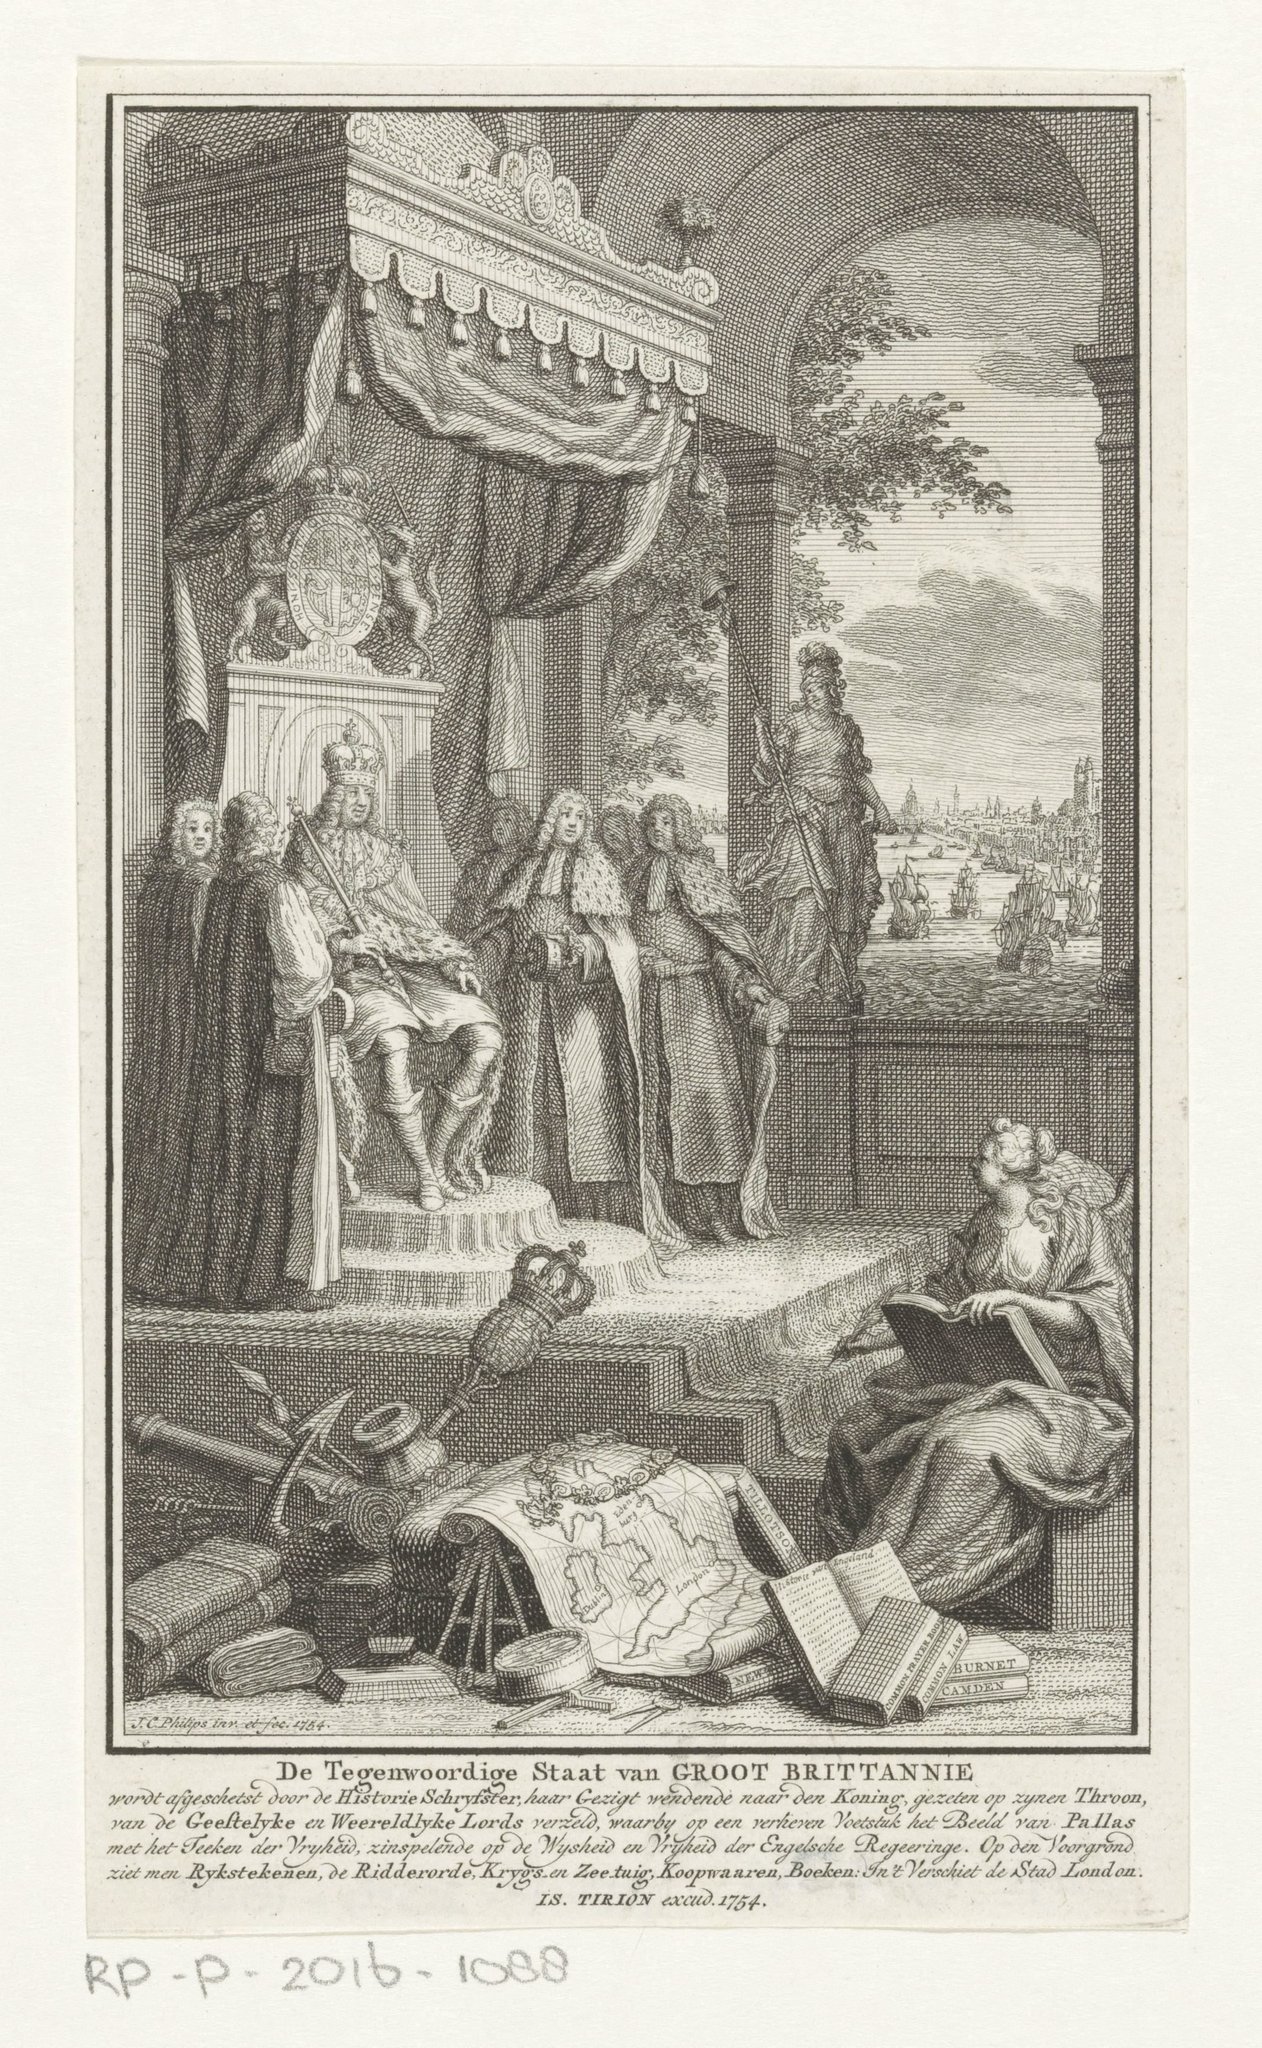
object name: titelblad, titelpagina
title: Titelpagina voor: Thomas Salmon, Hedendaagsche historie of tegenwoordige staat van Groot Brittannie, 1754.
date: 1754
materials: paper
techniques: engraving, etching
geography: amsterdam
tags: (story of) minerva (pallas, athena), 'historia'; 'historia' (ripa), king, great britain, london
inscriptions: collector's mark: Lugt 2228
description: Geschiedenis schrijft de historie van Groot-Brittannië. Zij kijkt naar een tronende koning omgeven door wereldlijke en geestelijke leiders. In een doorkijk naar buiten een beeld van Minerva met vrijheidshoed als personificatie van de wijsheid en vrijheid van de Engelse regering. Op de voorgrond liggen boeken, een kaart van de Britse eilanden, instrumenten gebruikt voor de zeevaart en handelswaar. In de achtergrond een gezicht op Londen.